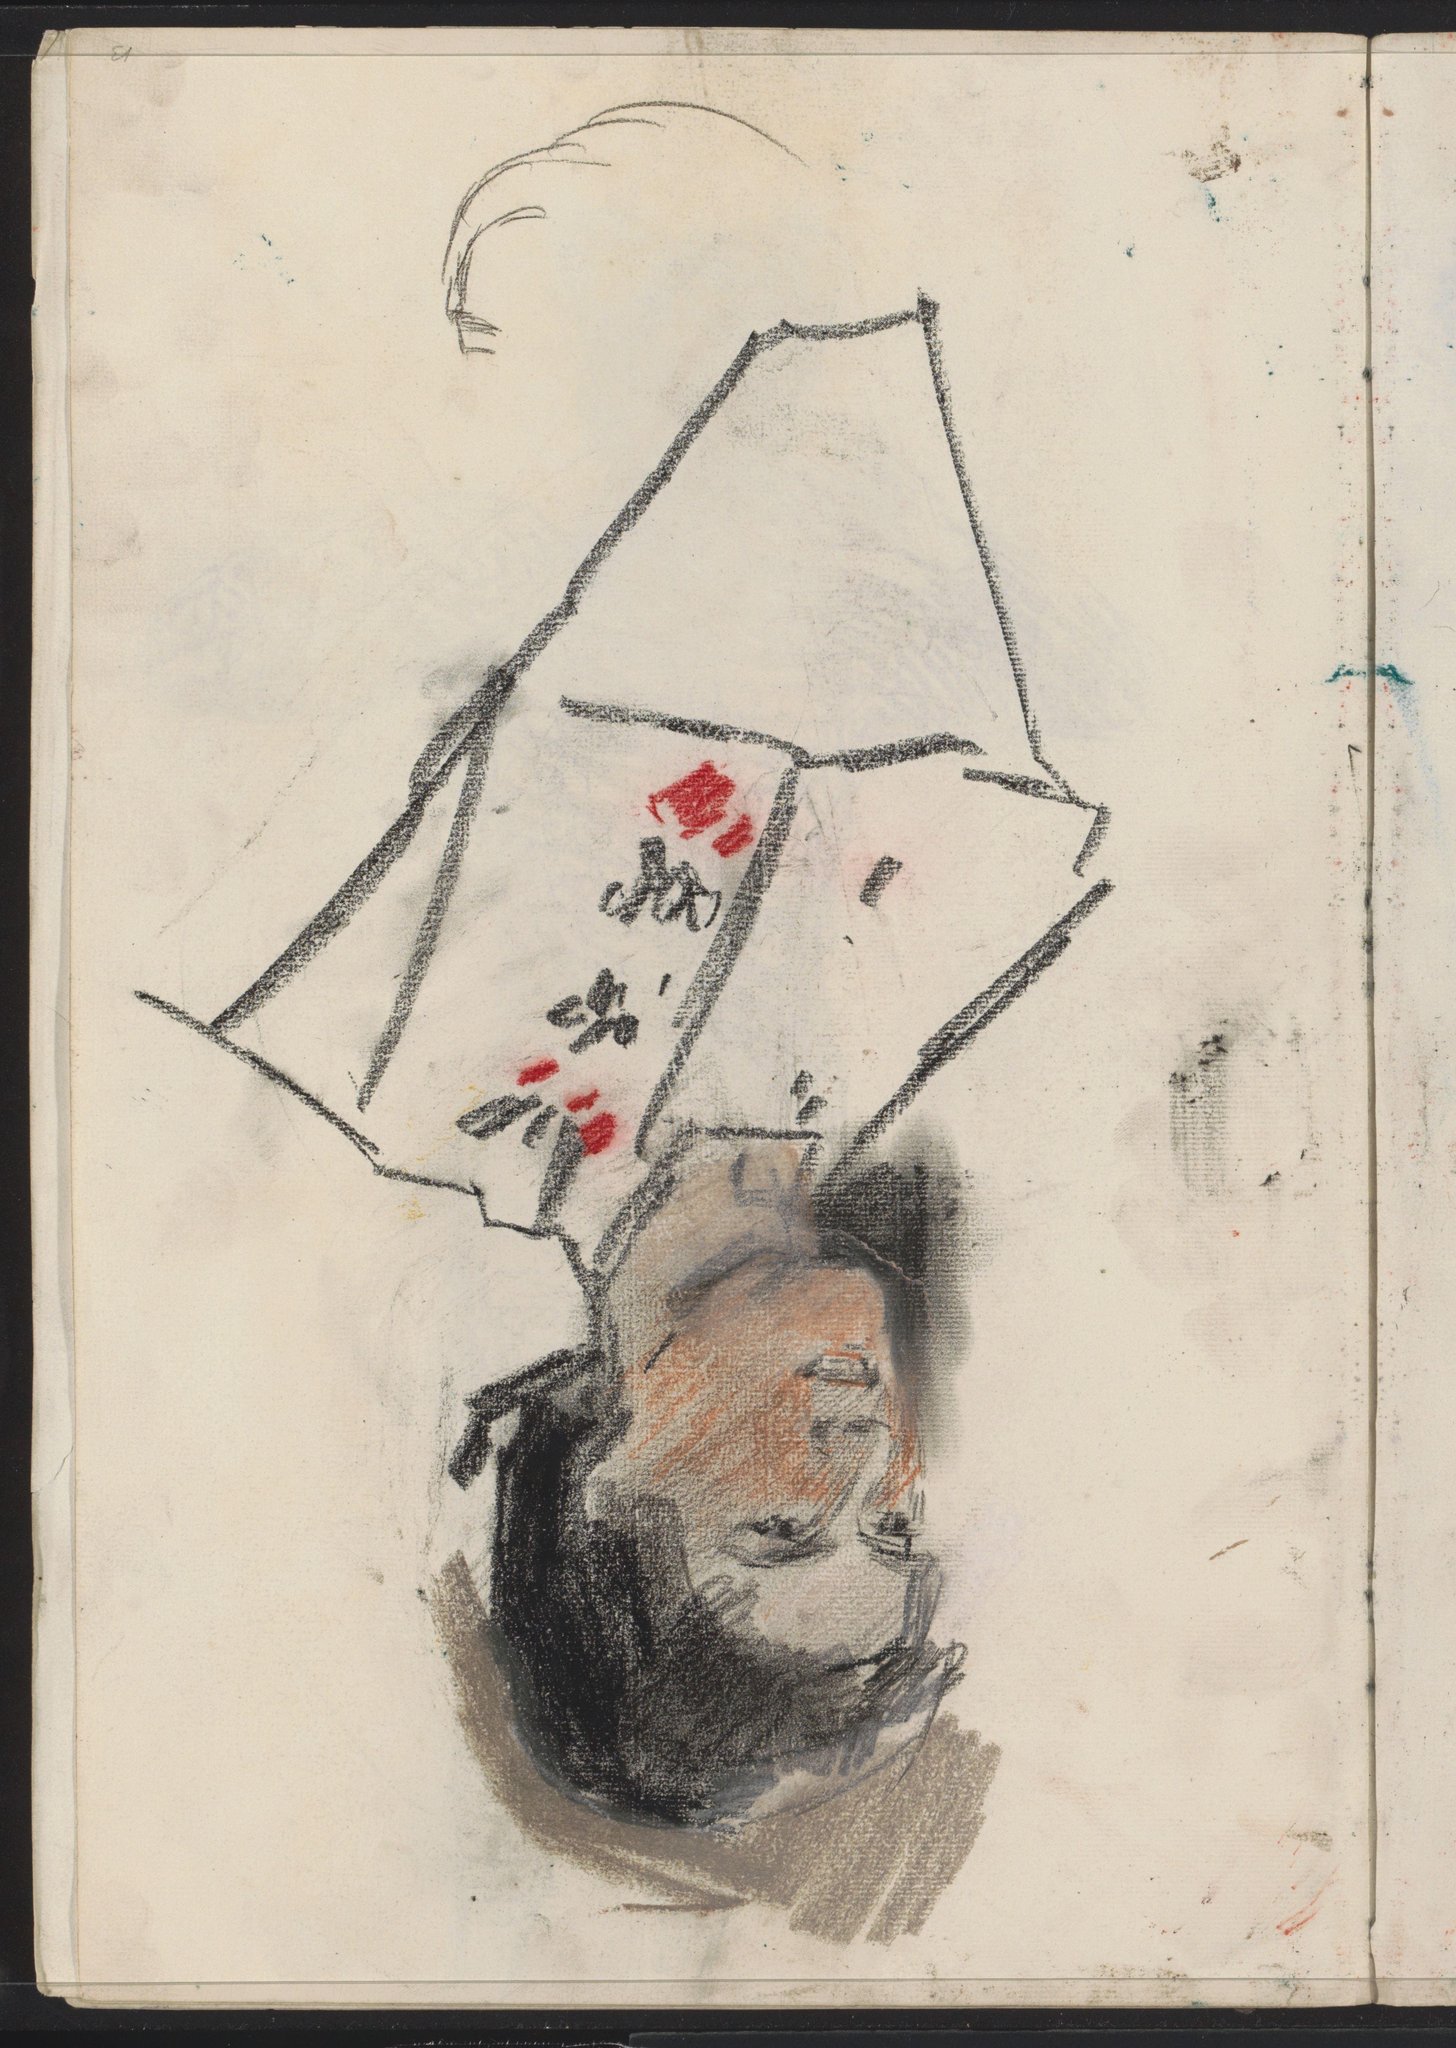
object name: sketchbook leaf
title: Portret van een onbekende vrouw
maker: isaac israels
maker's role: draughtsman, painter, print maker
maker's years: 1865-1934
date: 1875-1934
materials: chalk, paper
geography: the hague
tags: adult woman, stage costume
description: Blad 10 verso uit schetsboek LXVIII met 11 bladen.